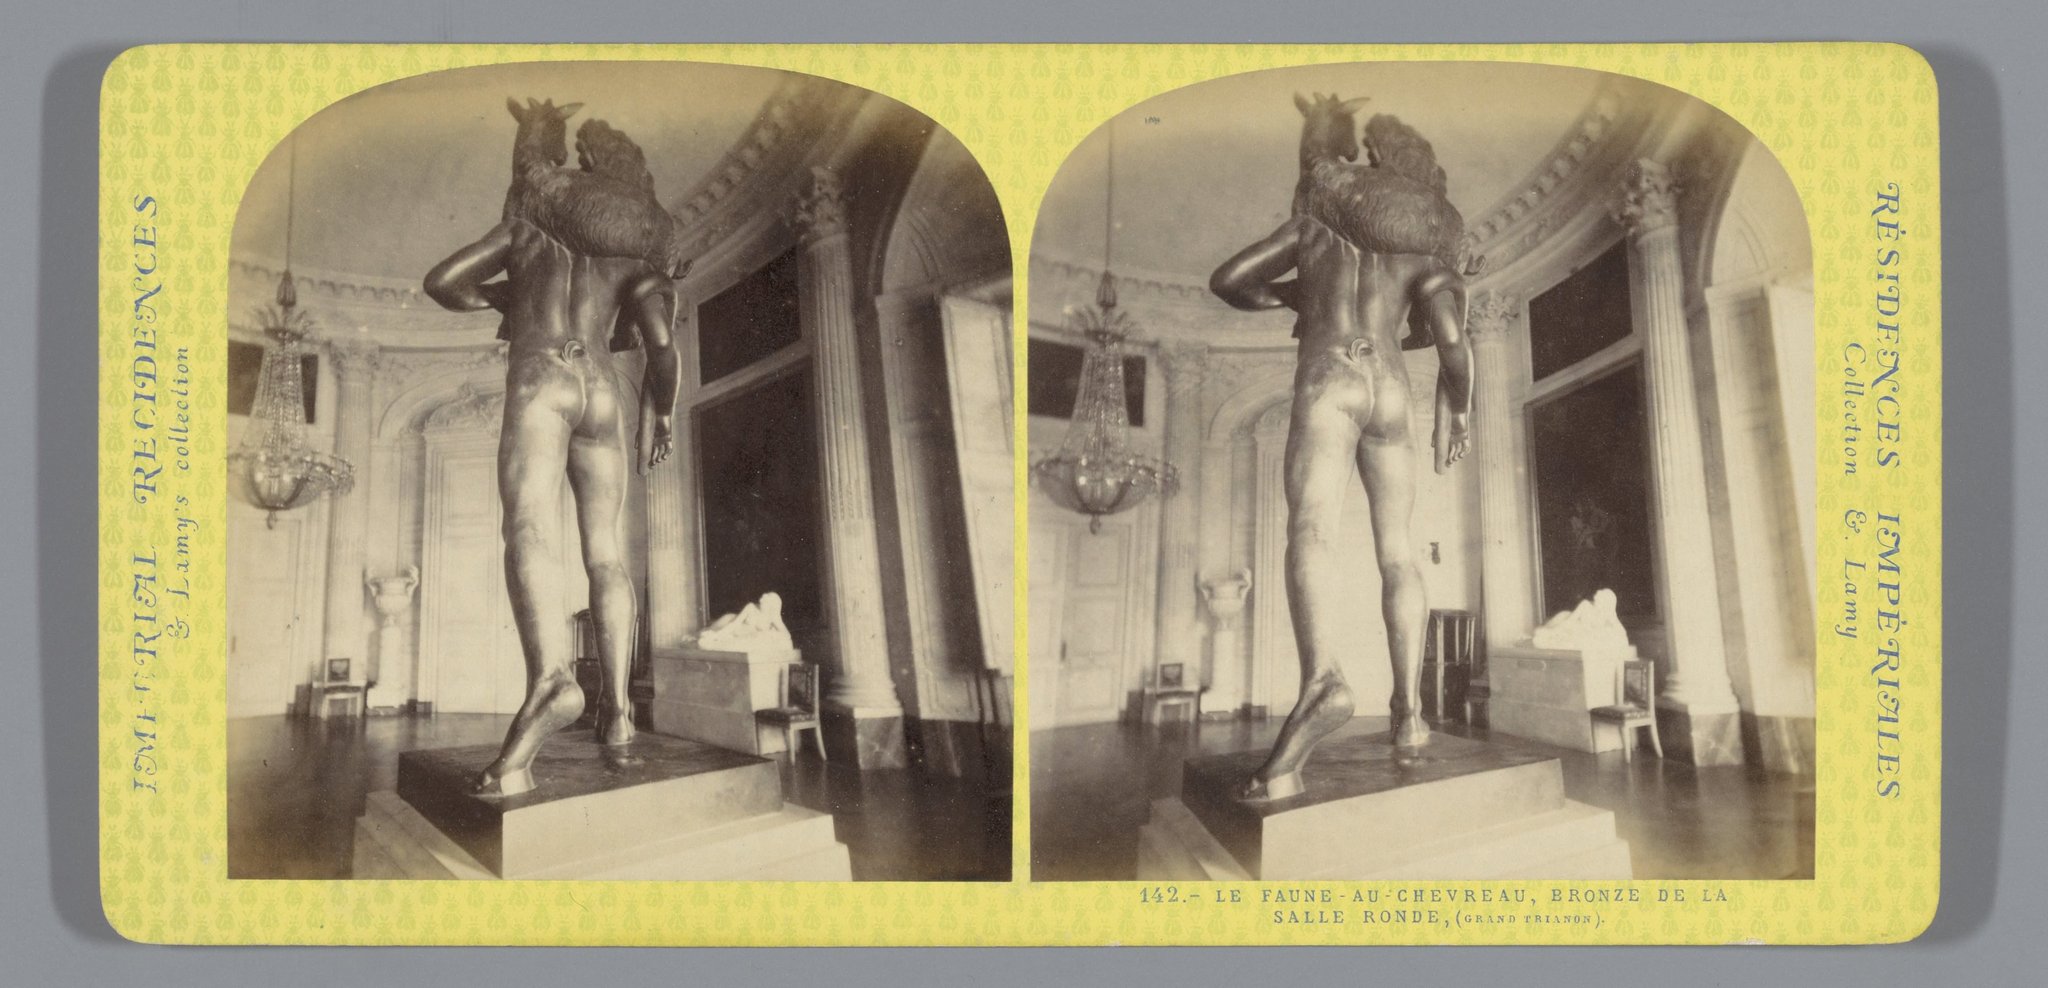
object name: stereograph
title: Le faune-au-chevreau, bronze de la salle ronde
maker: ernest eléonor pierre lamy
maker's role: publisher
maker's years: 1828-1900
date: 1860-1880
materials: cardboard, photographic support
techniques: albumen print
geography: grand trianon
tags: satyrs, fauns, sileni, he-goat, billy-goat, sculpture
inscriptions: number: ‘142.’, inscription: ‘E. Lamy's collection’